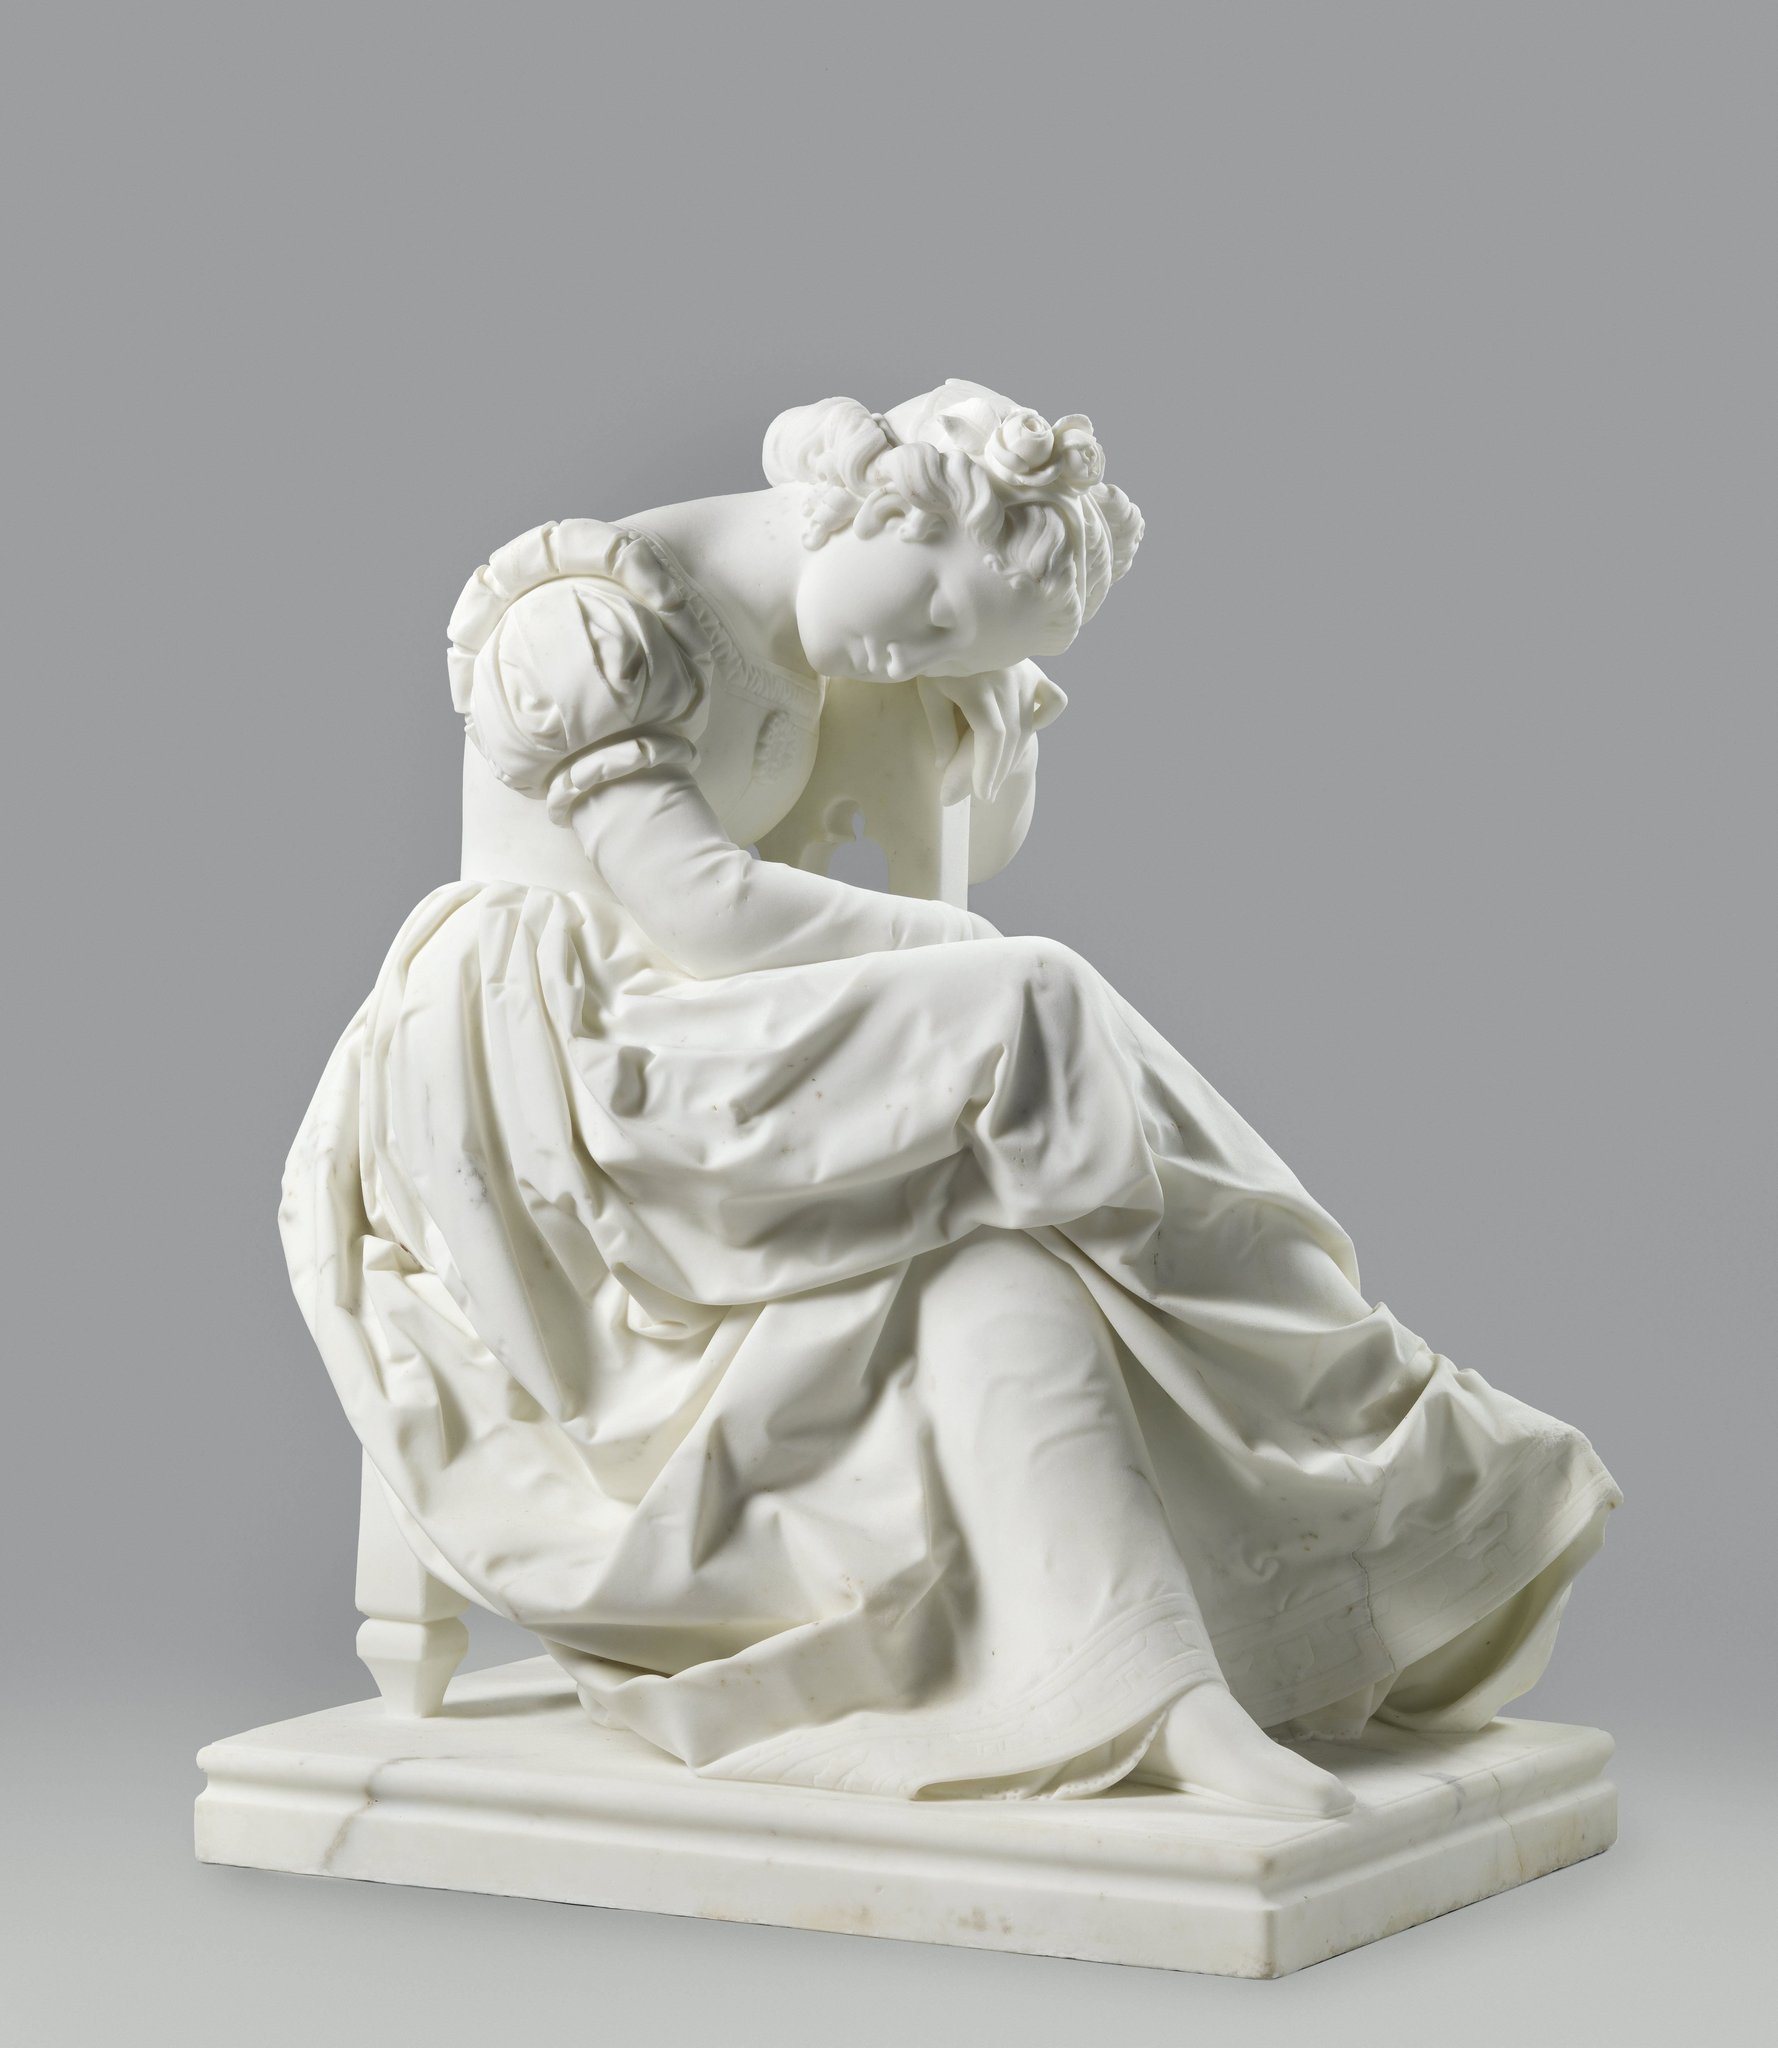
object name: sculpture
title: Sleeping Beauty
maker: frans stracké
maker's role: draughtsman, painter, sculptor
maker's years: 1820-1898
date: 1867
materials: marble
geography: arnhem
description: Few Dutch sculptors risked depicting romantic themes in the 19th century. Stracké’s Sleeping Beauty is, therefore, quite exceptional. He captured the fairy-tale princess in her deep, 100-year sleep, after she had pricked her finger on an enchanted spindle. She is rendered so realistically that the statue seems alive, as if she could awaken any moment.